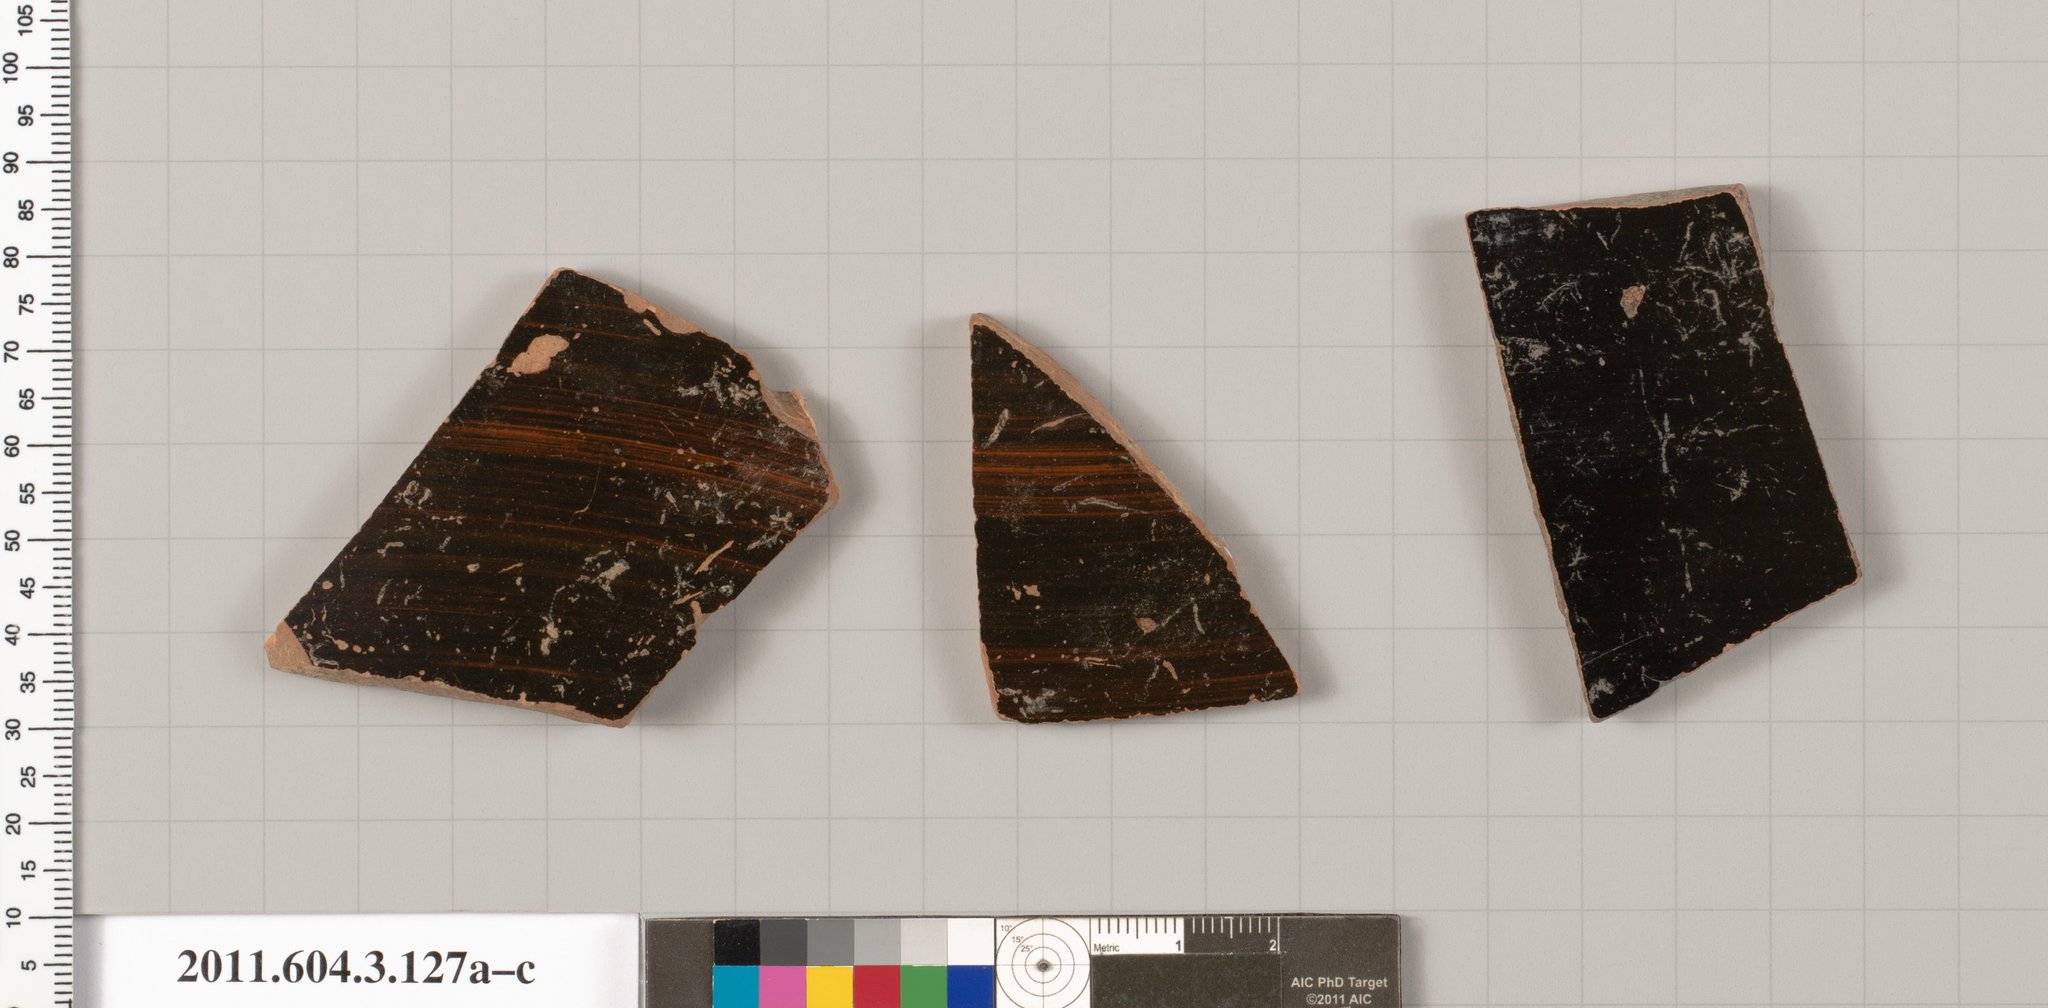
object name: amphora fragment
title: Terracotta fragments of amphorae (jars)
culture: greek, attic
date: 600-468 BCE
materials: terracotta